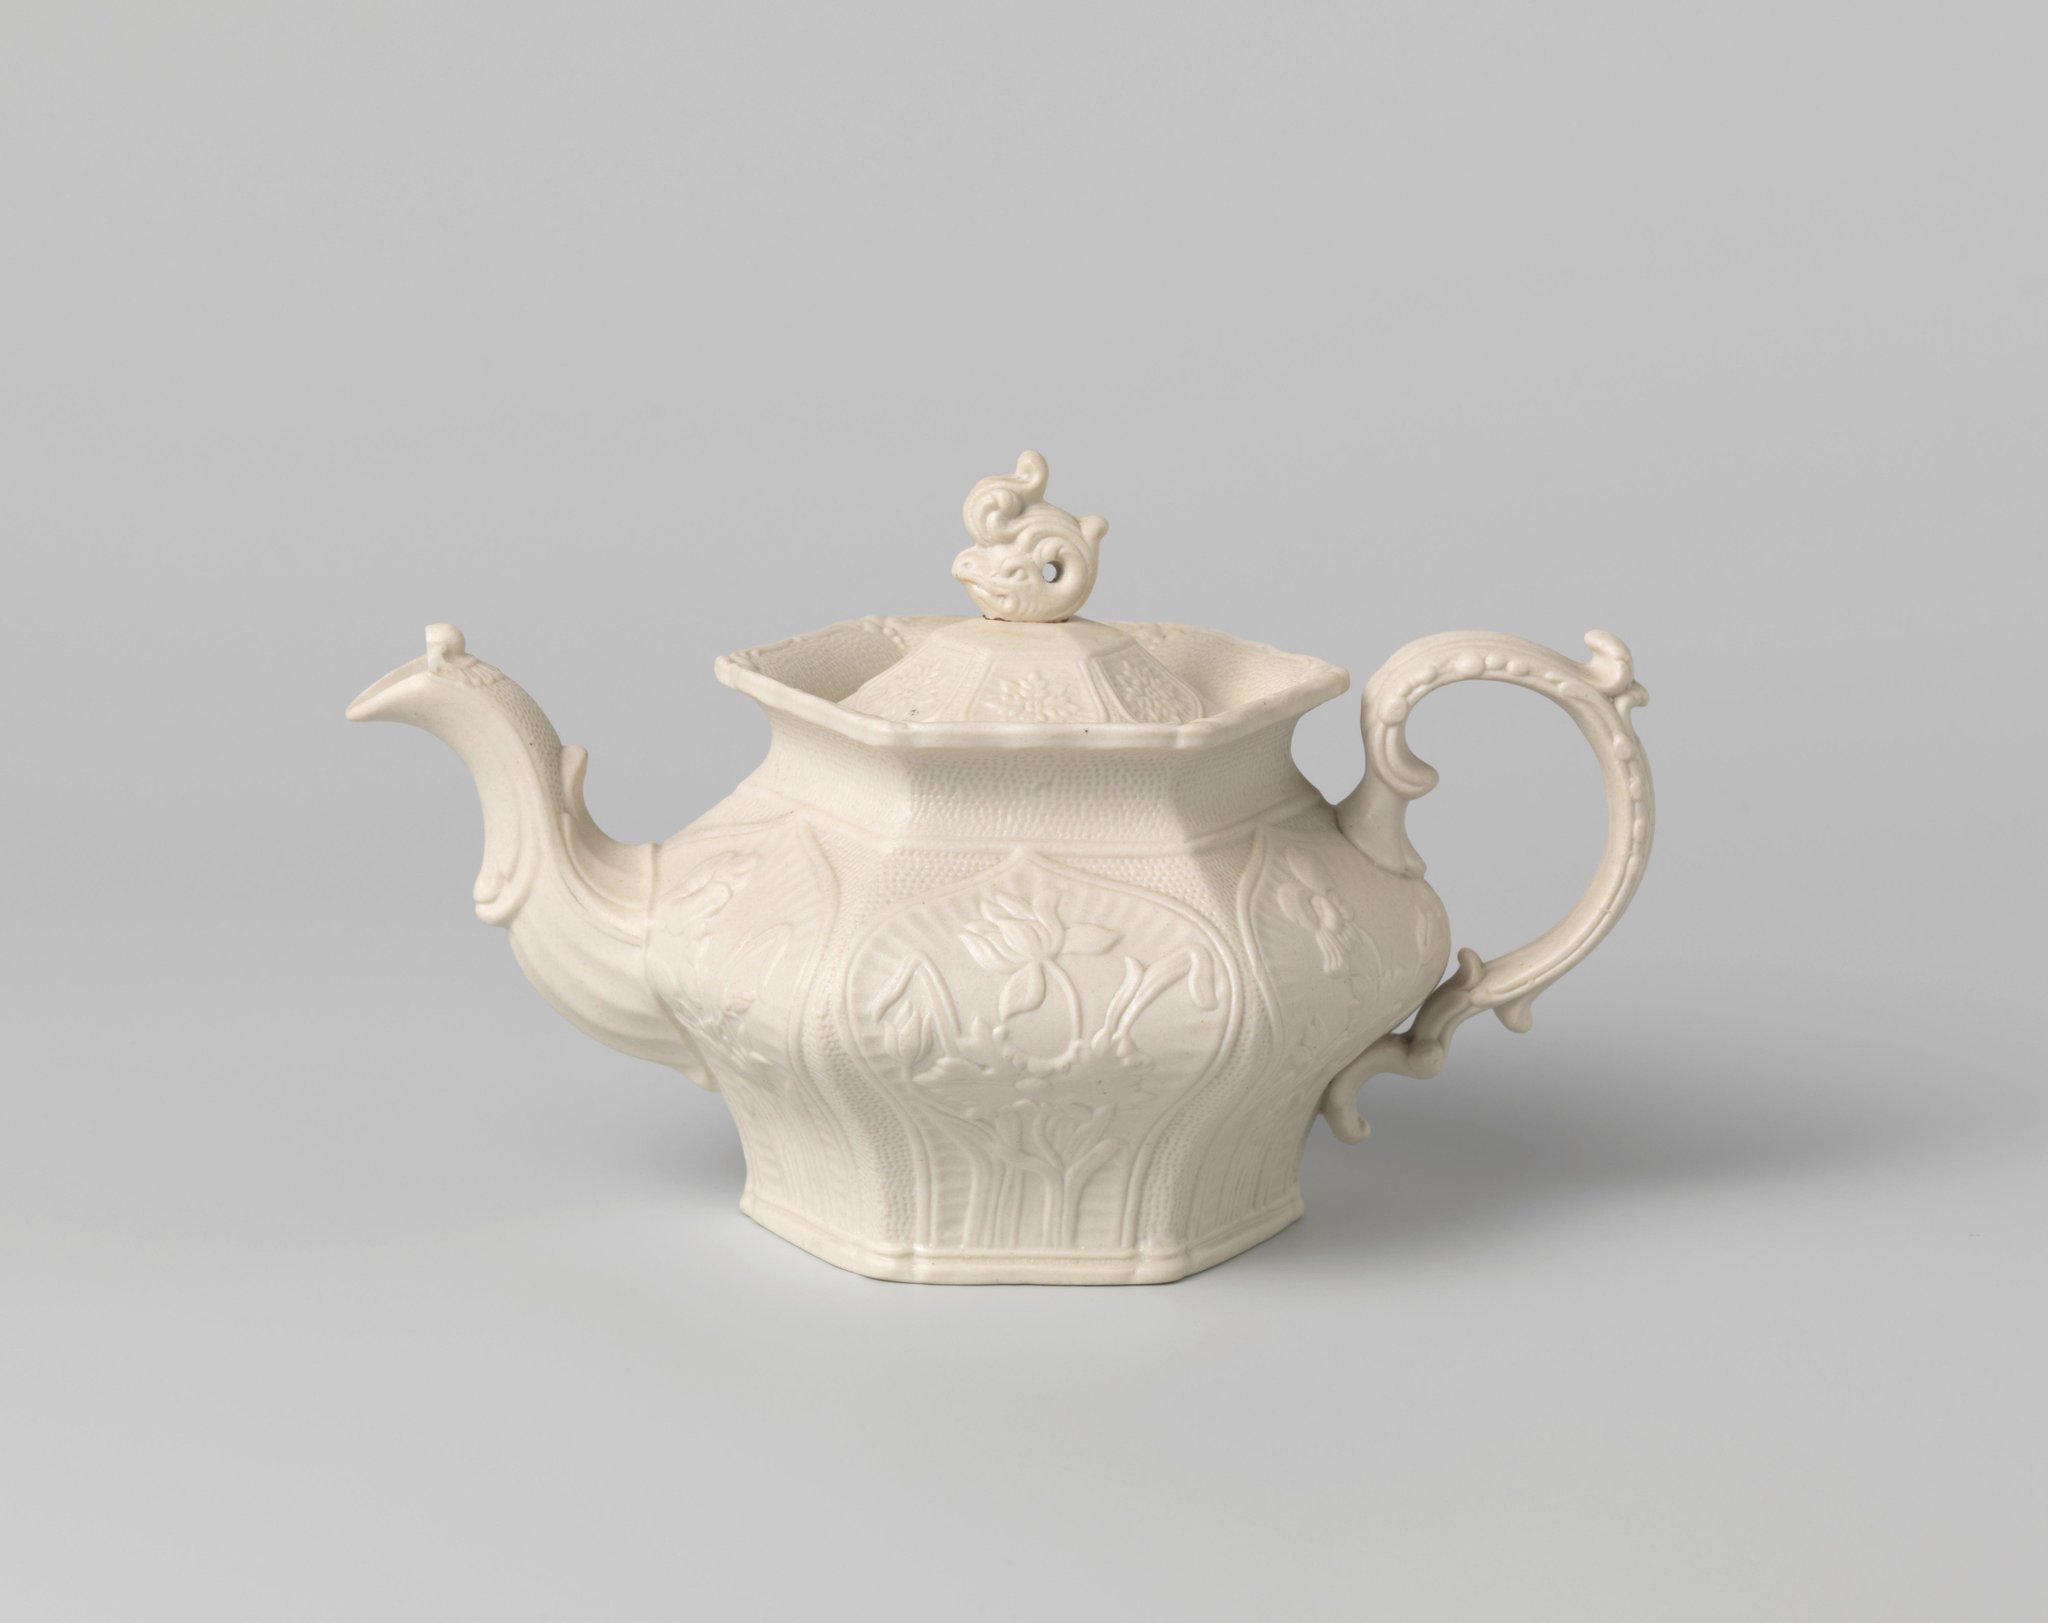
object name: teapot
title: Theepot met deksel, zeshoekig, gres blanc, met cartouches met bloemen in reliëf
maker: petrus regout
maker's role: plateelbakker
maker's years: 1801-1879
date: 1870-1890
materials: stoneware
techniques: vitrification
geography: maastricht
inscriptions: mark: ‘P. REGOUT // MAASTRICHT // 13’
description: Theepot van geglazuurd aardewerk, gres blanc. De zeshoekige pot is in reliëf gedecoreerd met zes ui-vormige cartouches met bloemen, tegen een gematteerde achtergrond. Het c-vormige oor is opgebouwd uit gestileerde bladeren. De s-vormige tuit is voorzien van voluutachtige reliëfversieringen. Het zeshoekige deksel is in reliëf gedecoreerd met zes ui-vormige cartouches tegen een gematteerde achtergrond, waarin bloemen in reliëf. In het deksel een luchtgat.